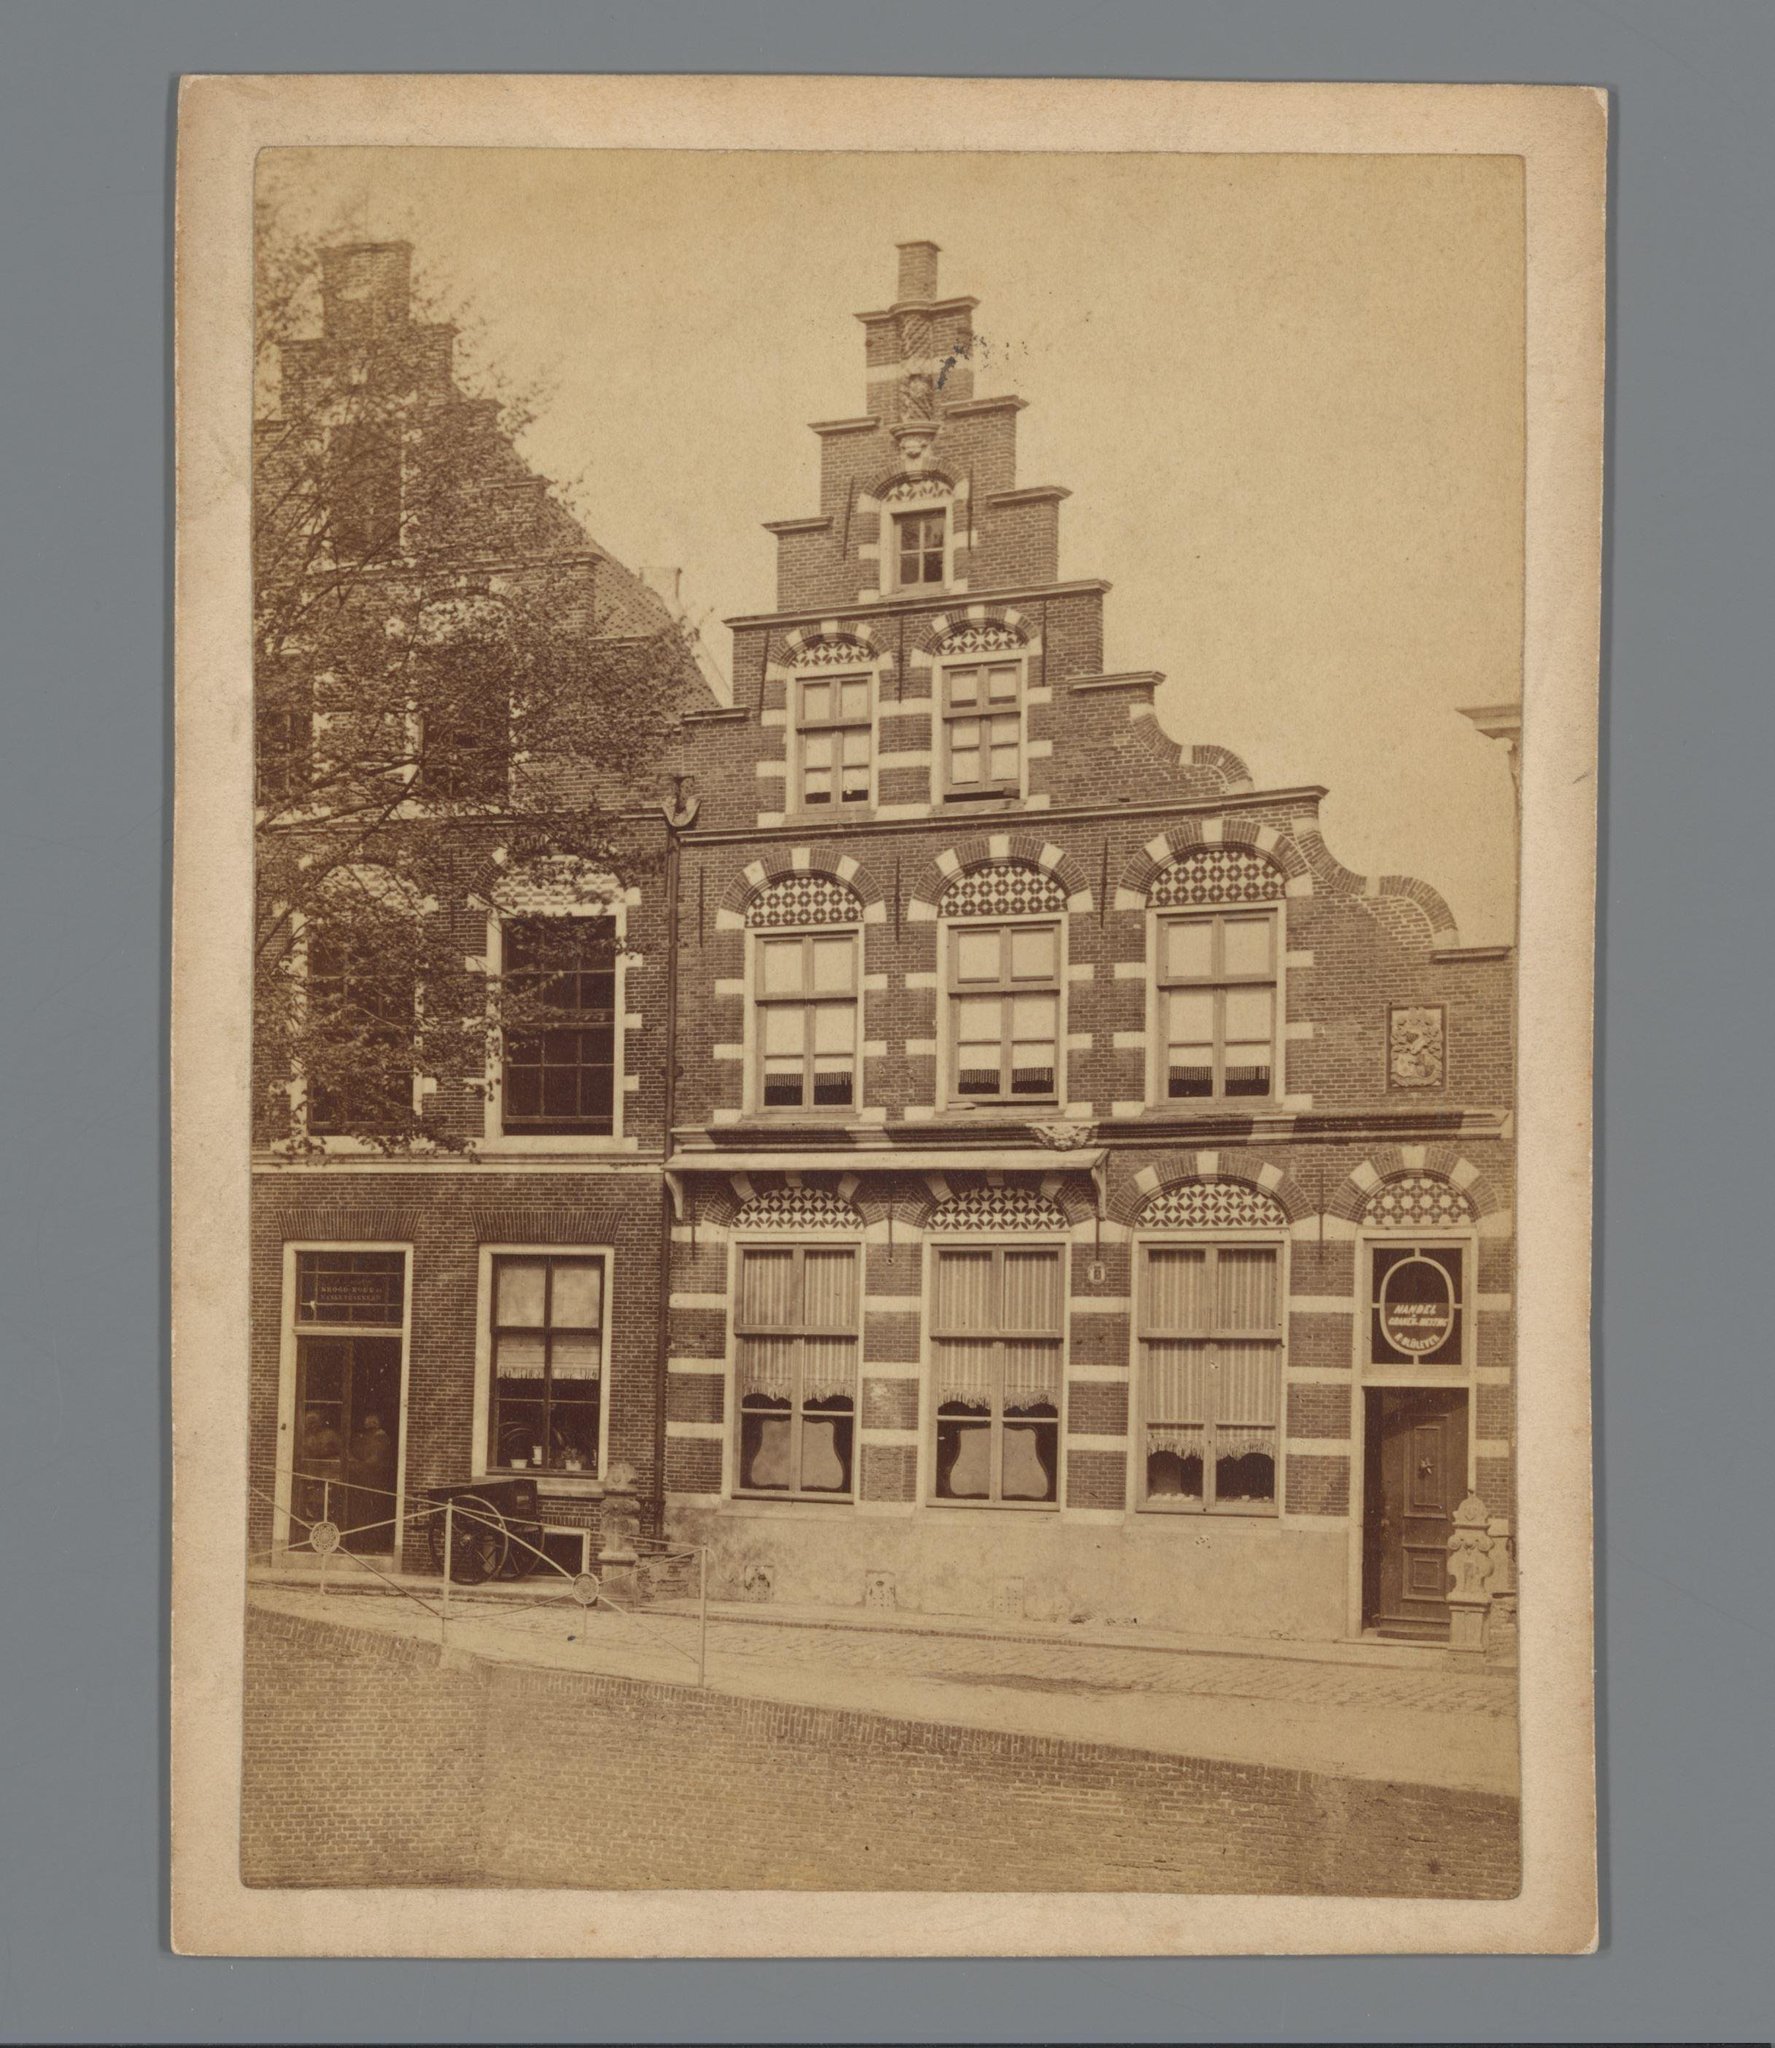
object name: photograph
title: Gevel van een huis, zeer waarschijnlijk Markt-Oostzijde 2 te Oudewater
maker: Anonymous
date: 1870-1900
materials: cardboard, photographic support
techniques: albumen print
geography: enkhuizen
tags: urban housing, façade (of house or building), enkhuizen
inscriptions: annotation: ‘Enkhuizen?’